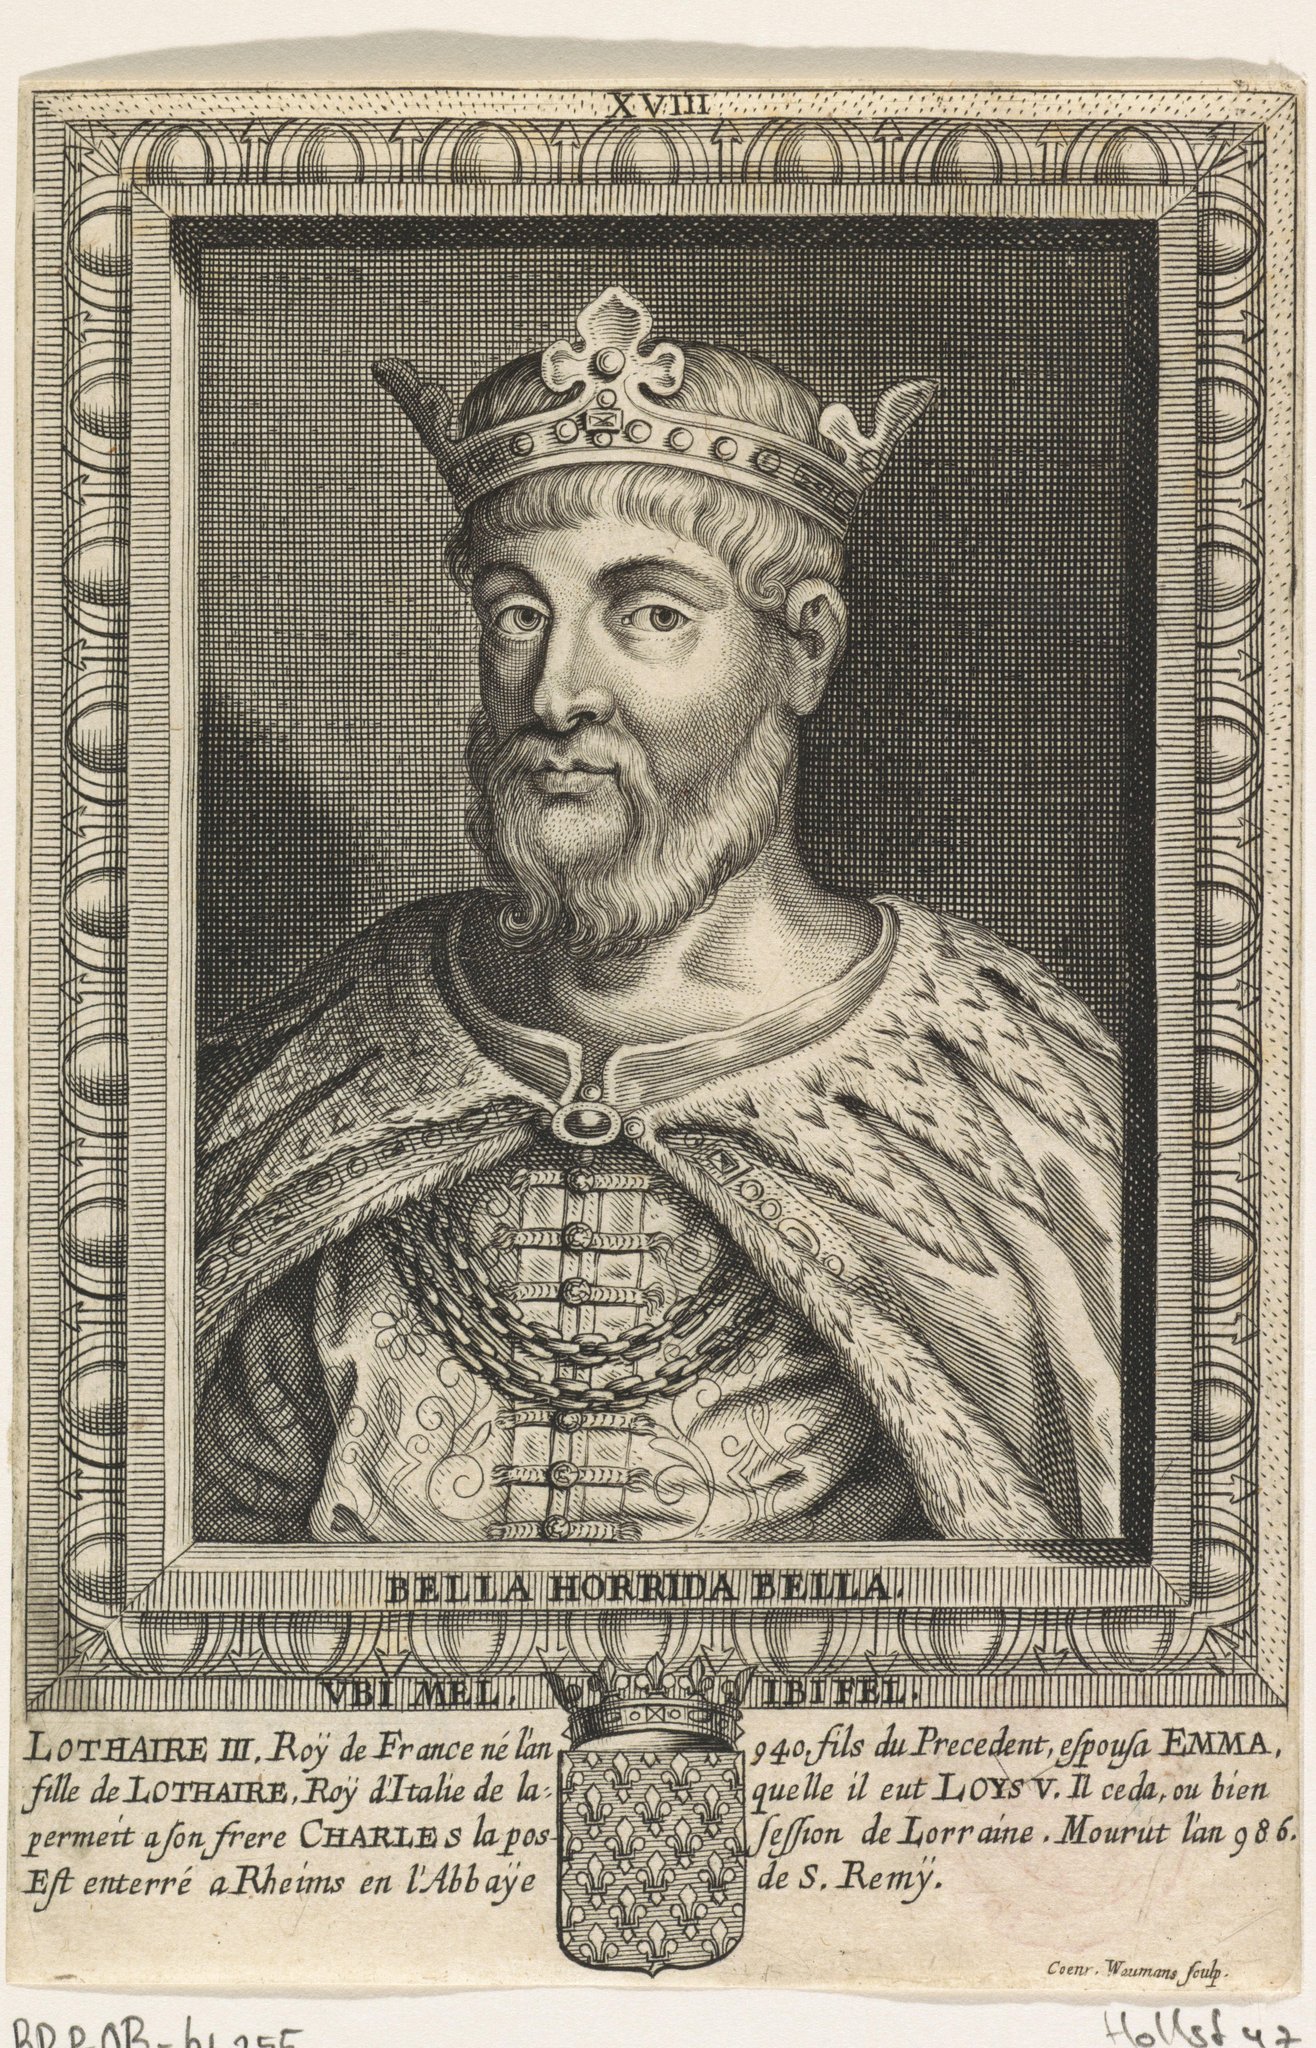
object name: print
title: Portret van Lotharius III van Frankrijk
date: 1662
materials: paper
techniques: engraving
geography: antwerp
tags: armorial bearing, heraldry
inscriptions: collector's mark: Lugt 240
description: Prent gebruikt in: Meyssens, C. Les pourtraits des souverains princes et comtes de Hollande. Antwerpen: J. Meyssens, 1662. Op de frontispiece wordt Richard Collin specifiek genoemd als graveur van de wapenschilden op de prenten in deze uitgave.